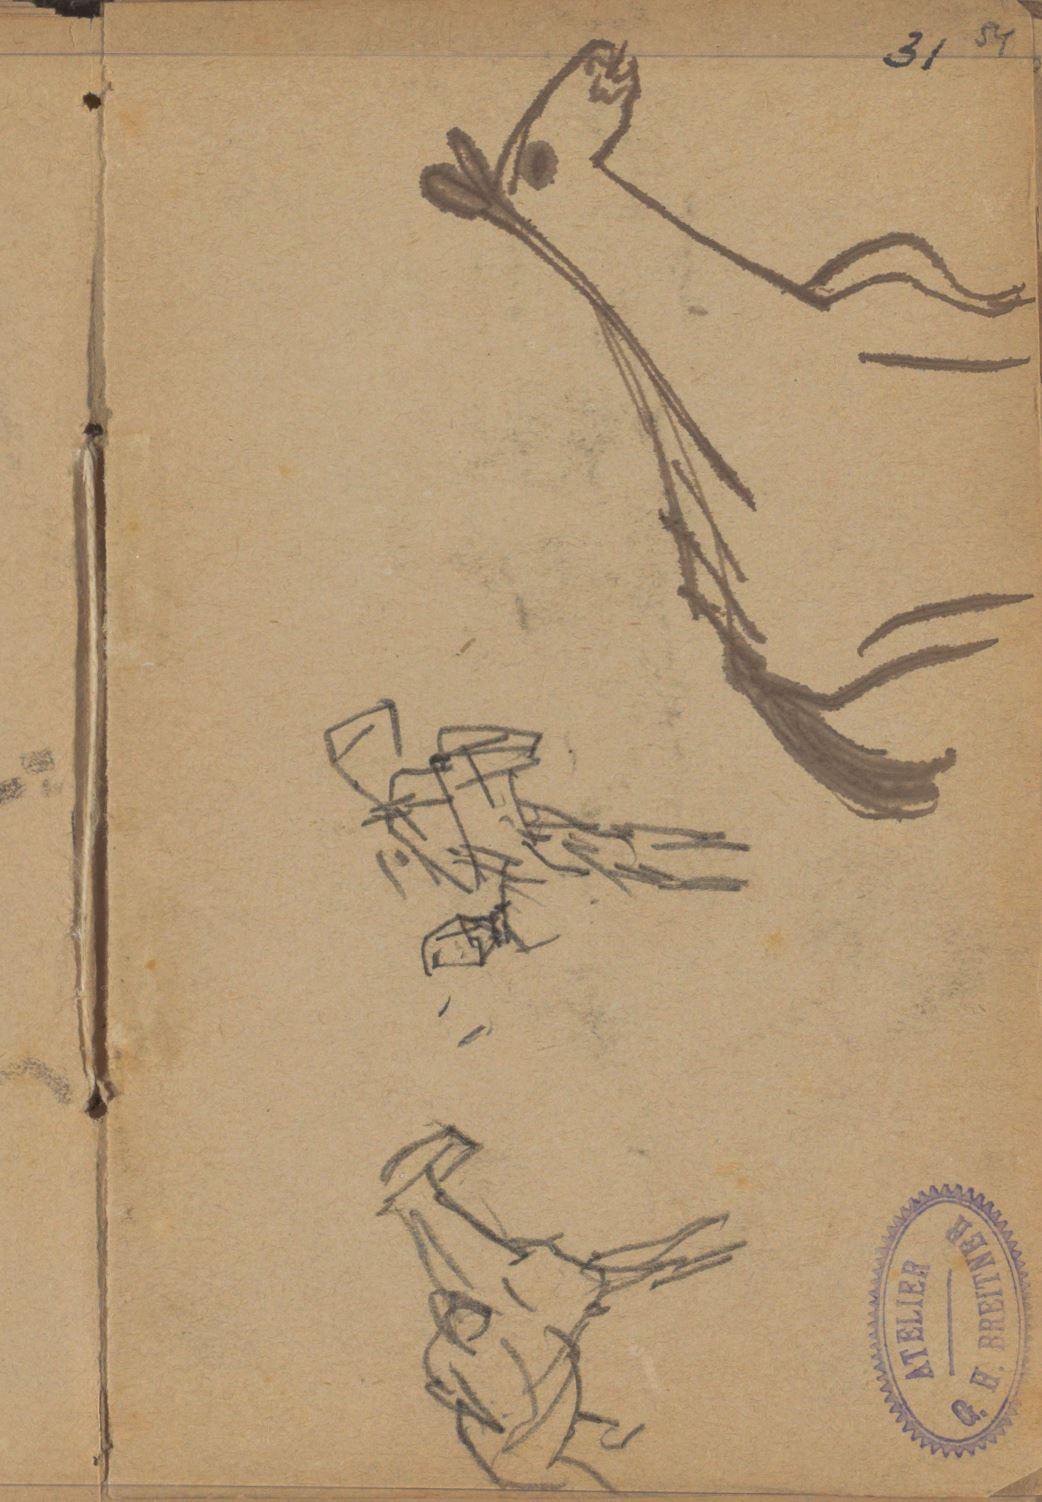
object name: sketchbook leaf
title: Paarden en een soldaat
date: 1887-1891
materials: ink, paper, pencil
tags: the soldier; the soldier's life, horse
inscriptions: workshop stamp: Lugt 291d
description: Pagina 54 uit een schetsboek met 83 bladen.